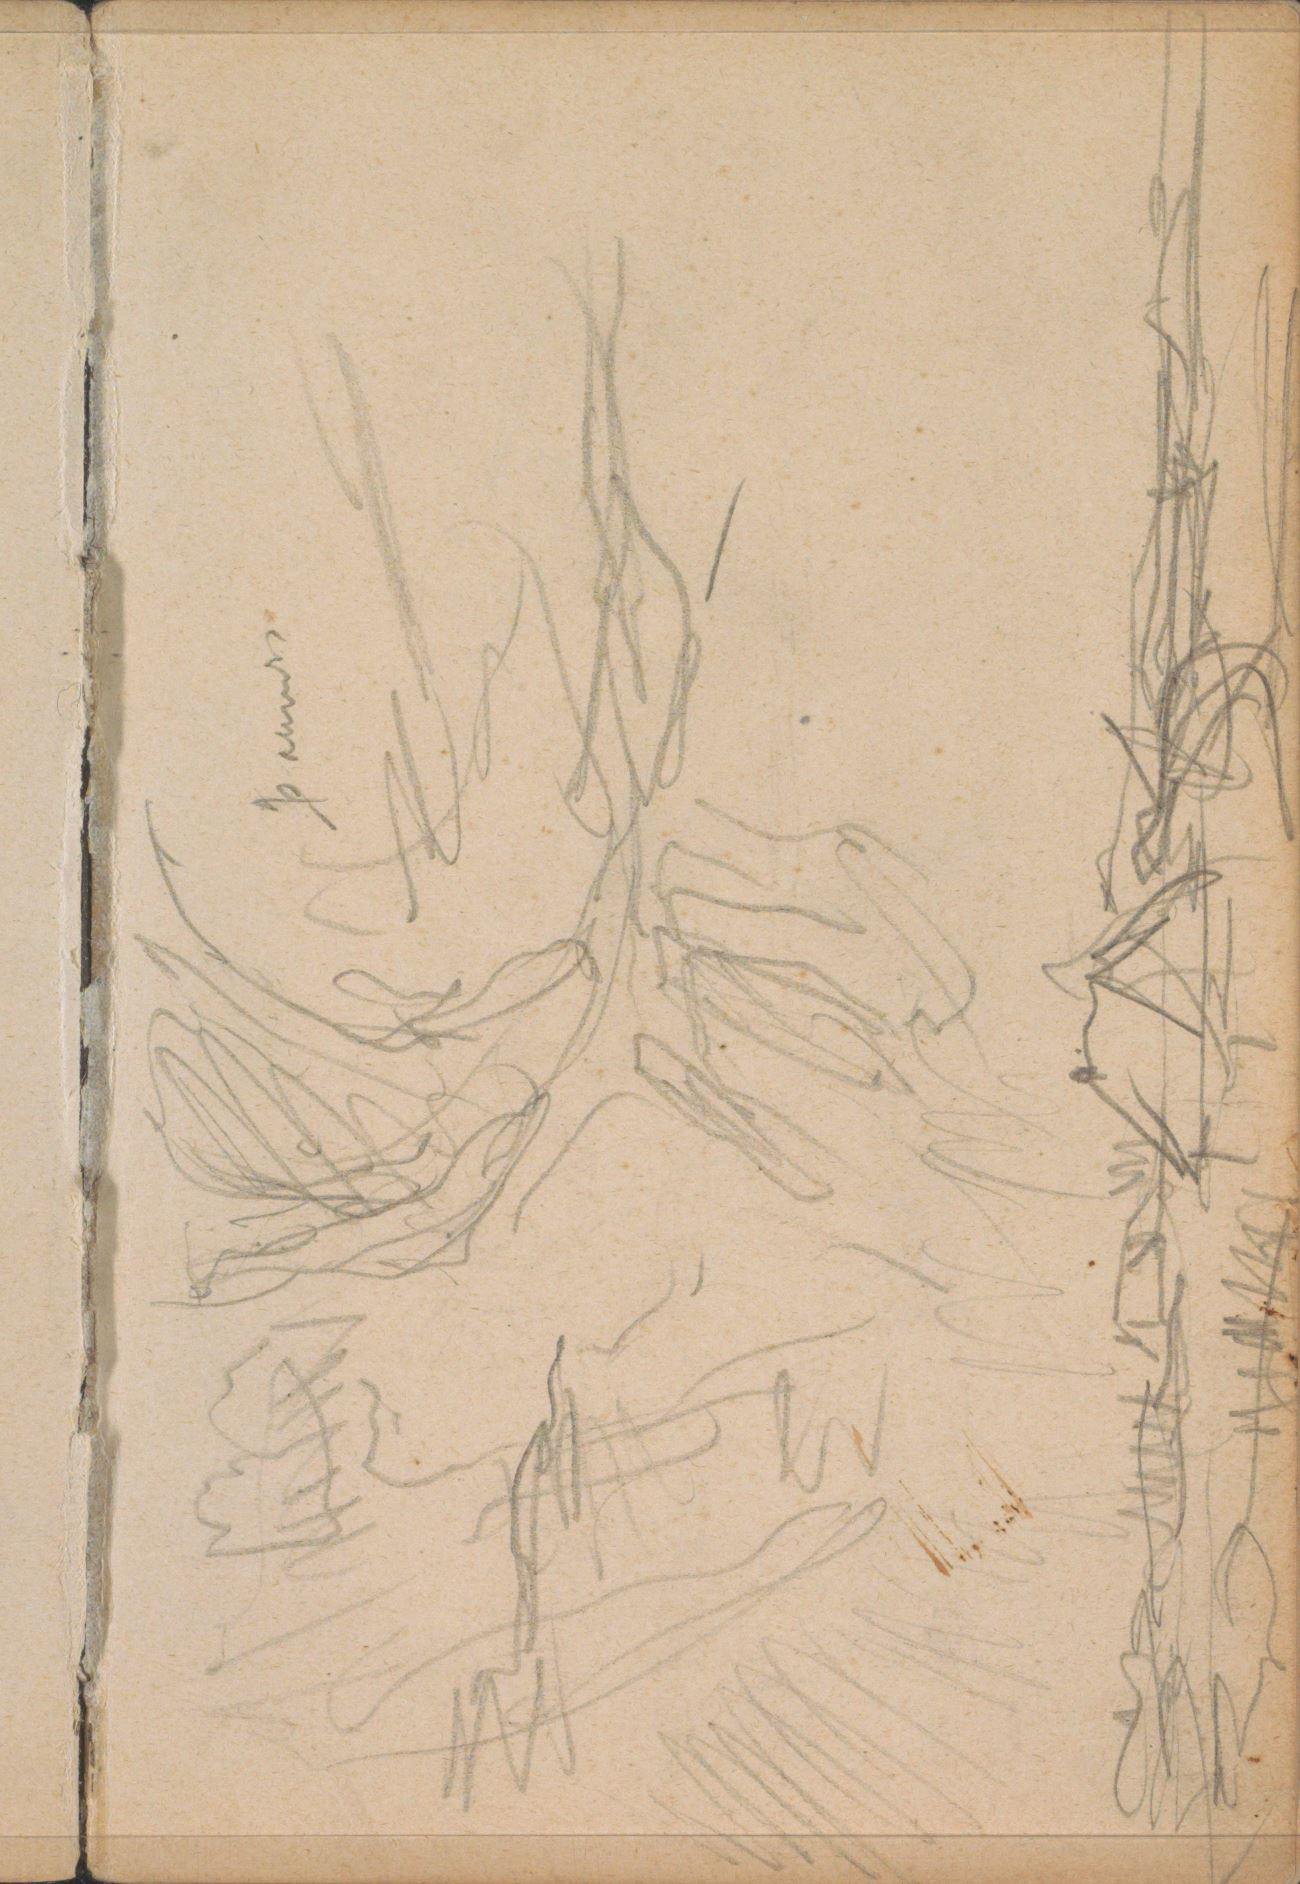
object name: sketchbook leaf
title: Landschap met bebouwing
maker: george hendrik breitner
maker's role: draughtsman, painter, print maker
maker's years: 1857-1923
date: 1886-1908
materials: paper, pencil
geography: north holland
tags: landscapes, clouds, rural housing, e.g. country-house, villa, cottage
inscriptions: kleurnotitie, handgeschreven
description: Pagina 24 uit een schetsboek met 46 bladen vervaardigd te Amsterdam, Haarlem en Antwerpen.